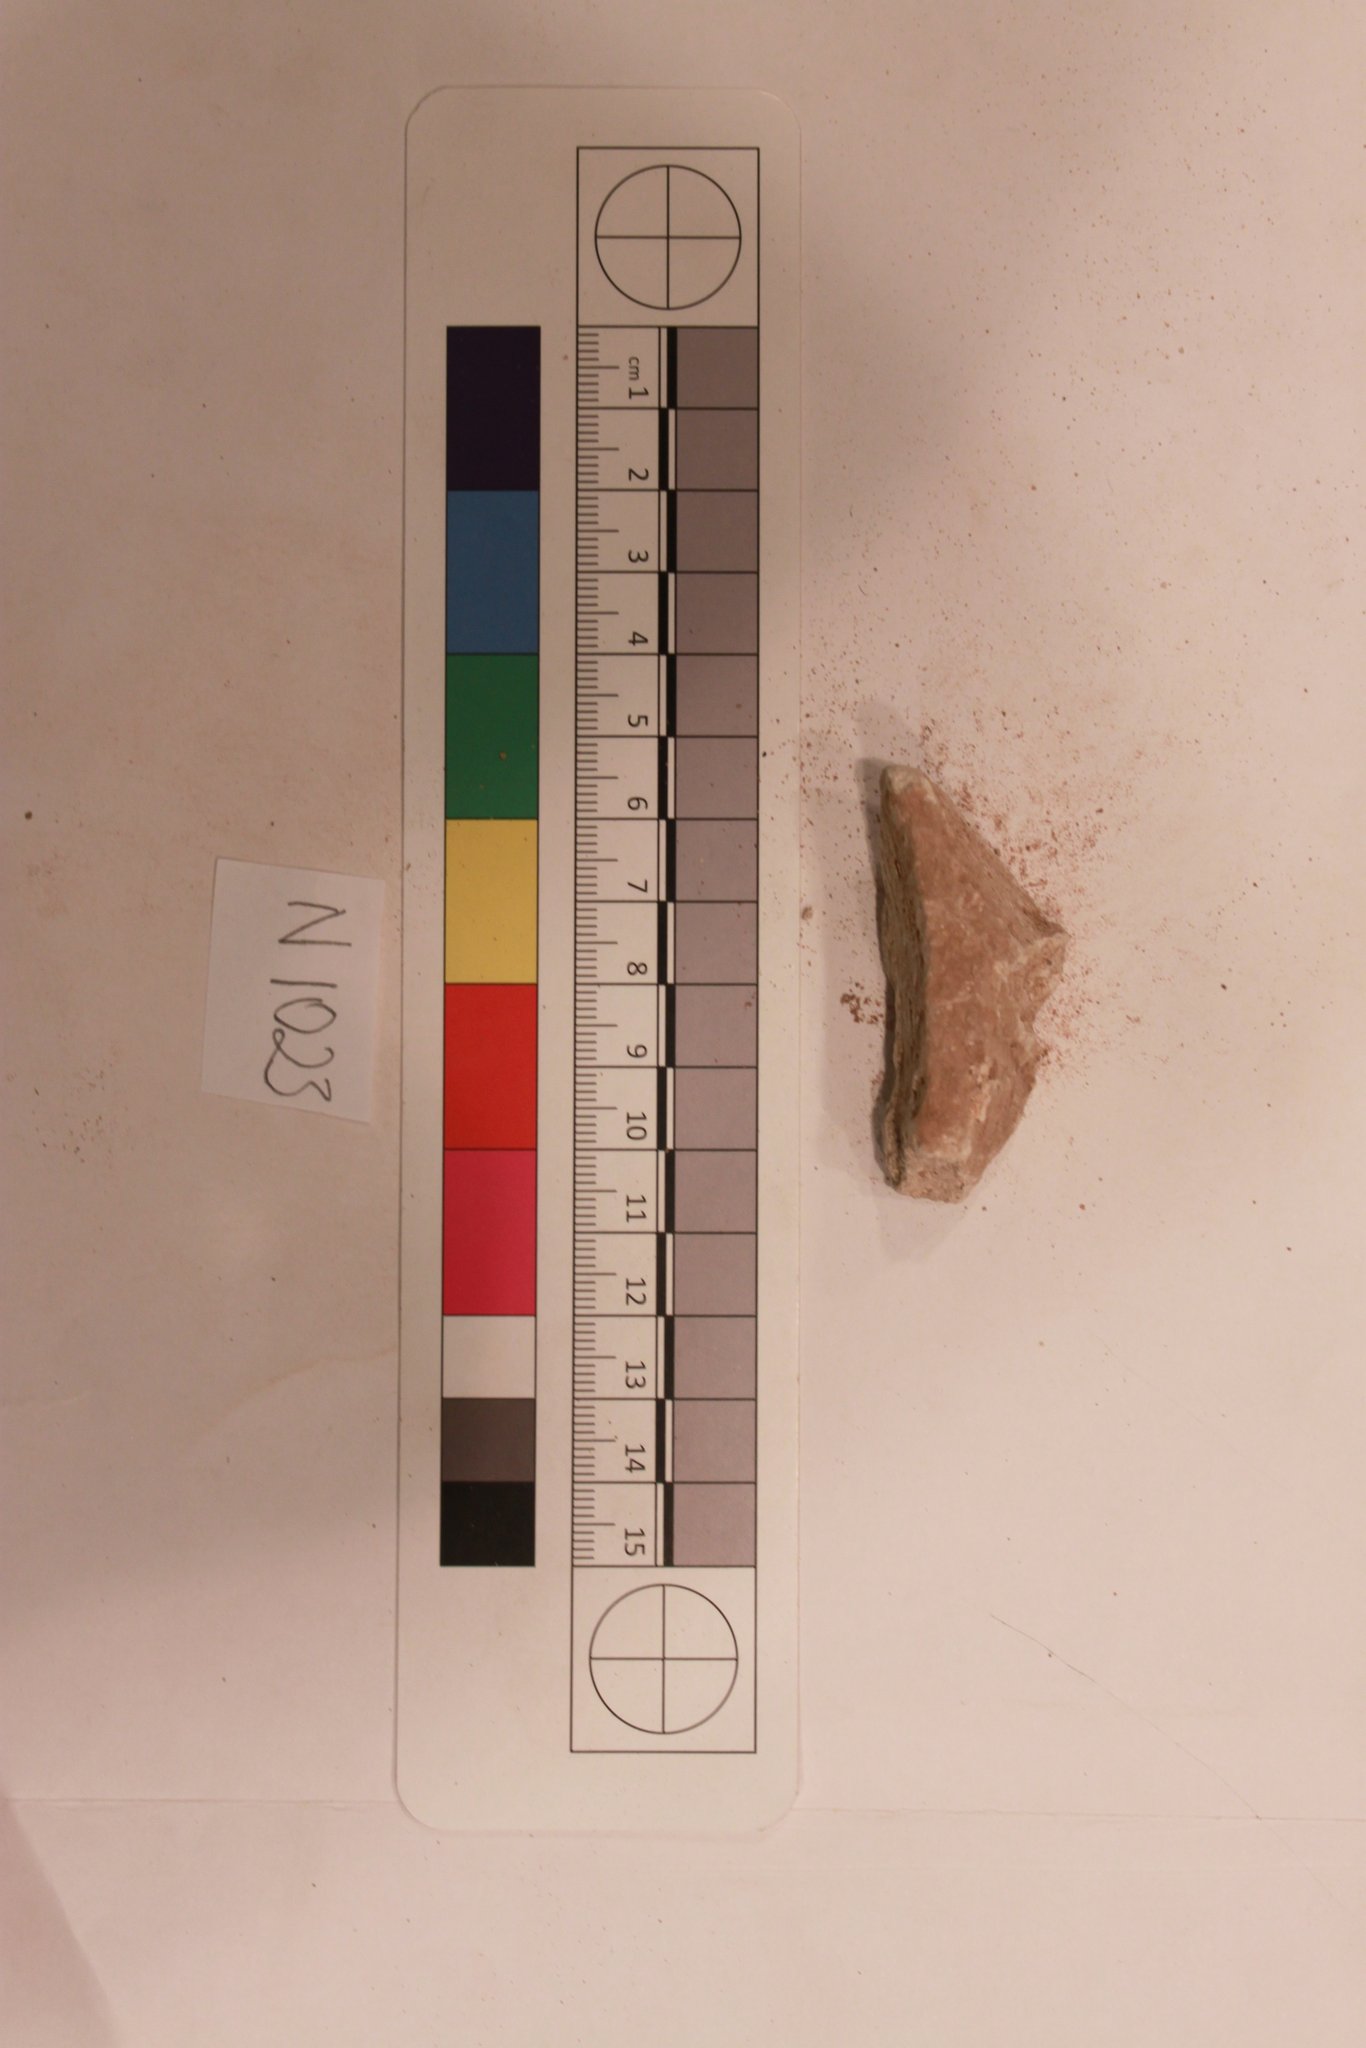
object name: fragment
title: Stucco Fragment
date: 701-1200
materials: plaster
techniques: carving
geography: iran